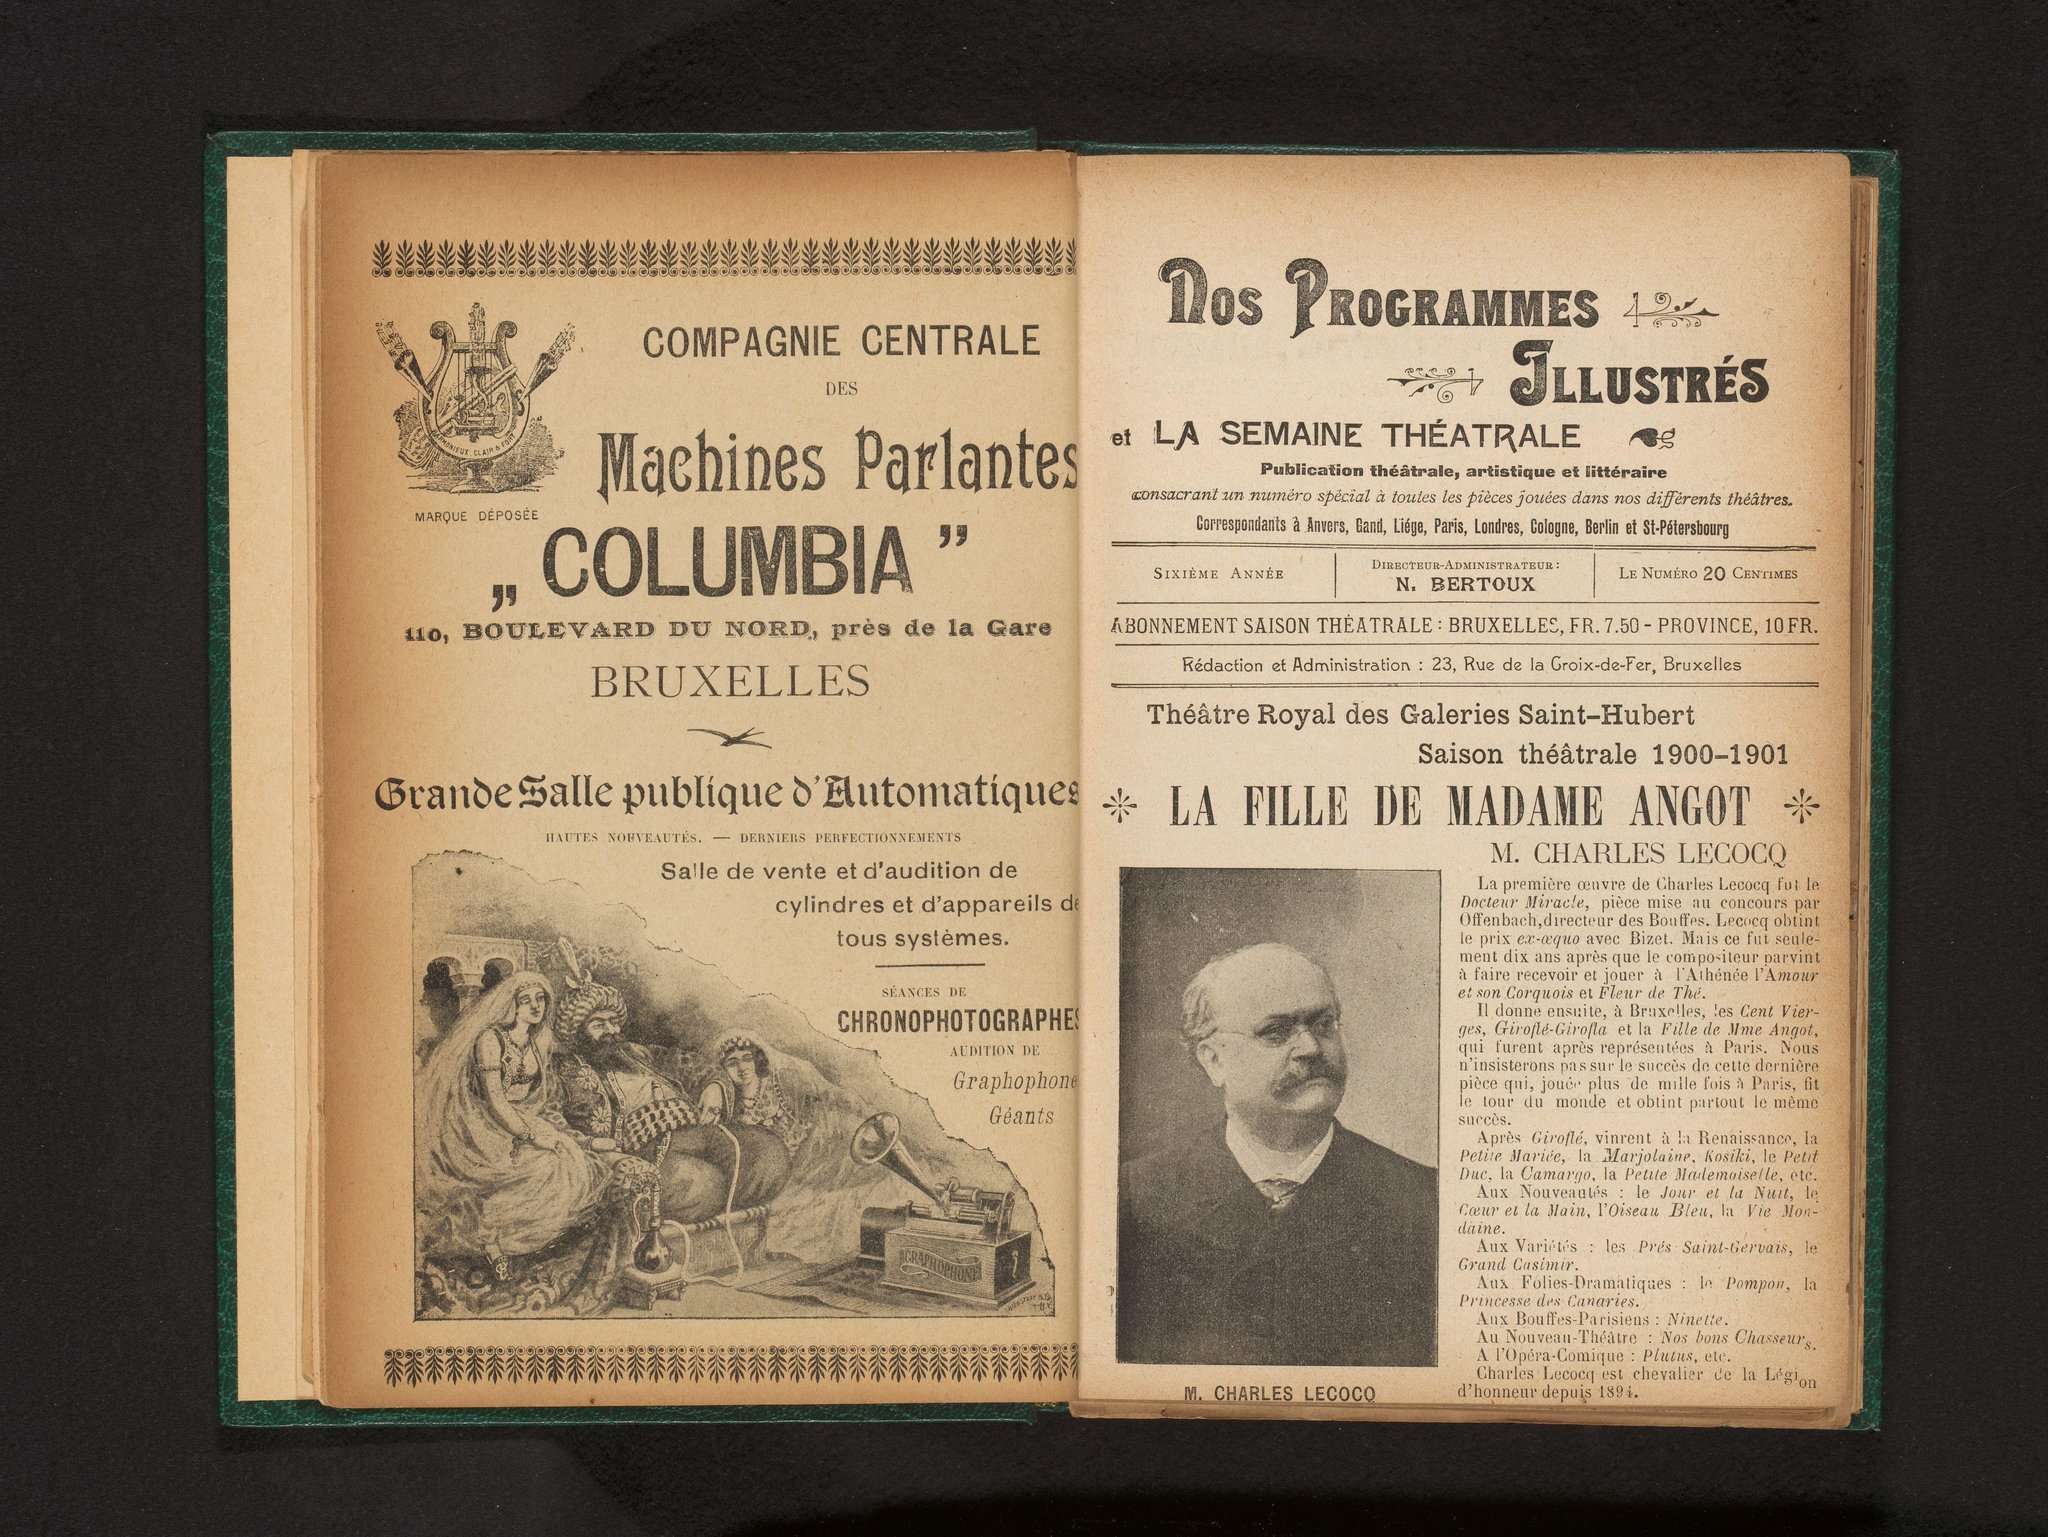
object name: page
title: M. Charles Lecocq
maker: Anonymous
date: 1895-1900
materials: paper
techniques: autotype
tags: adult man, historical persons